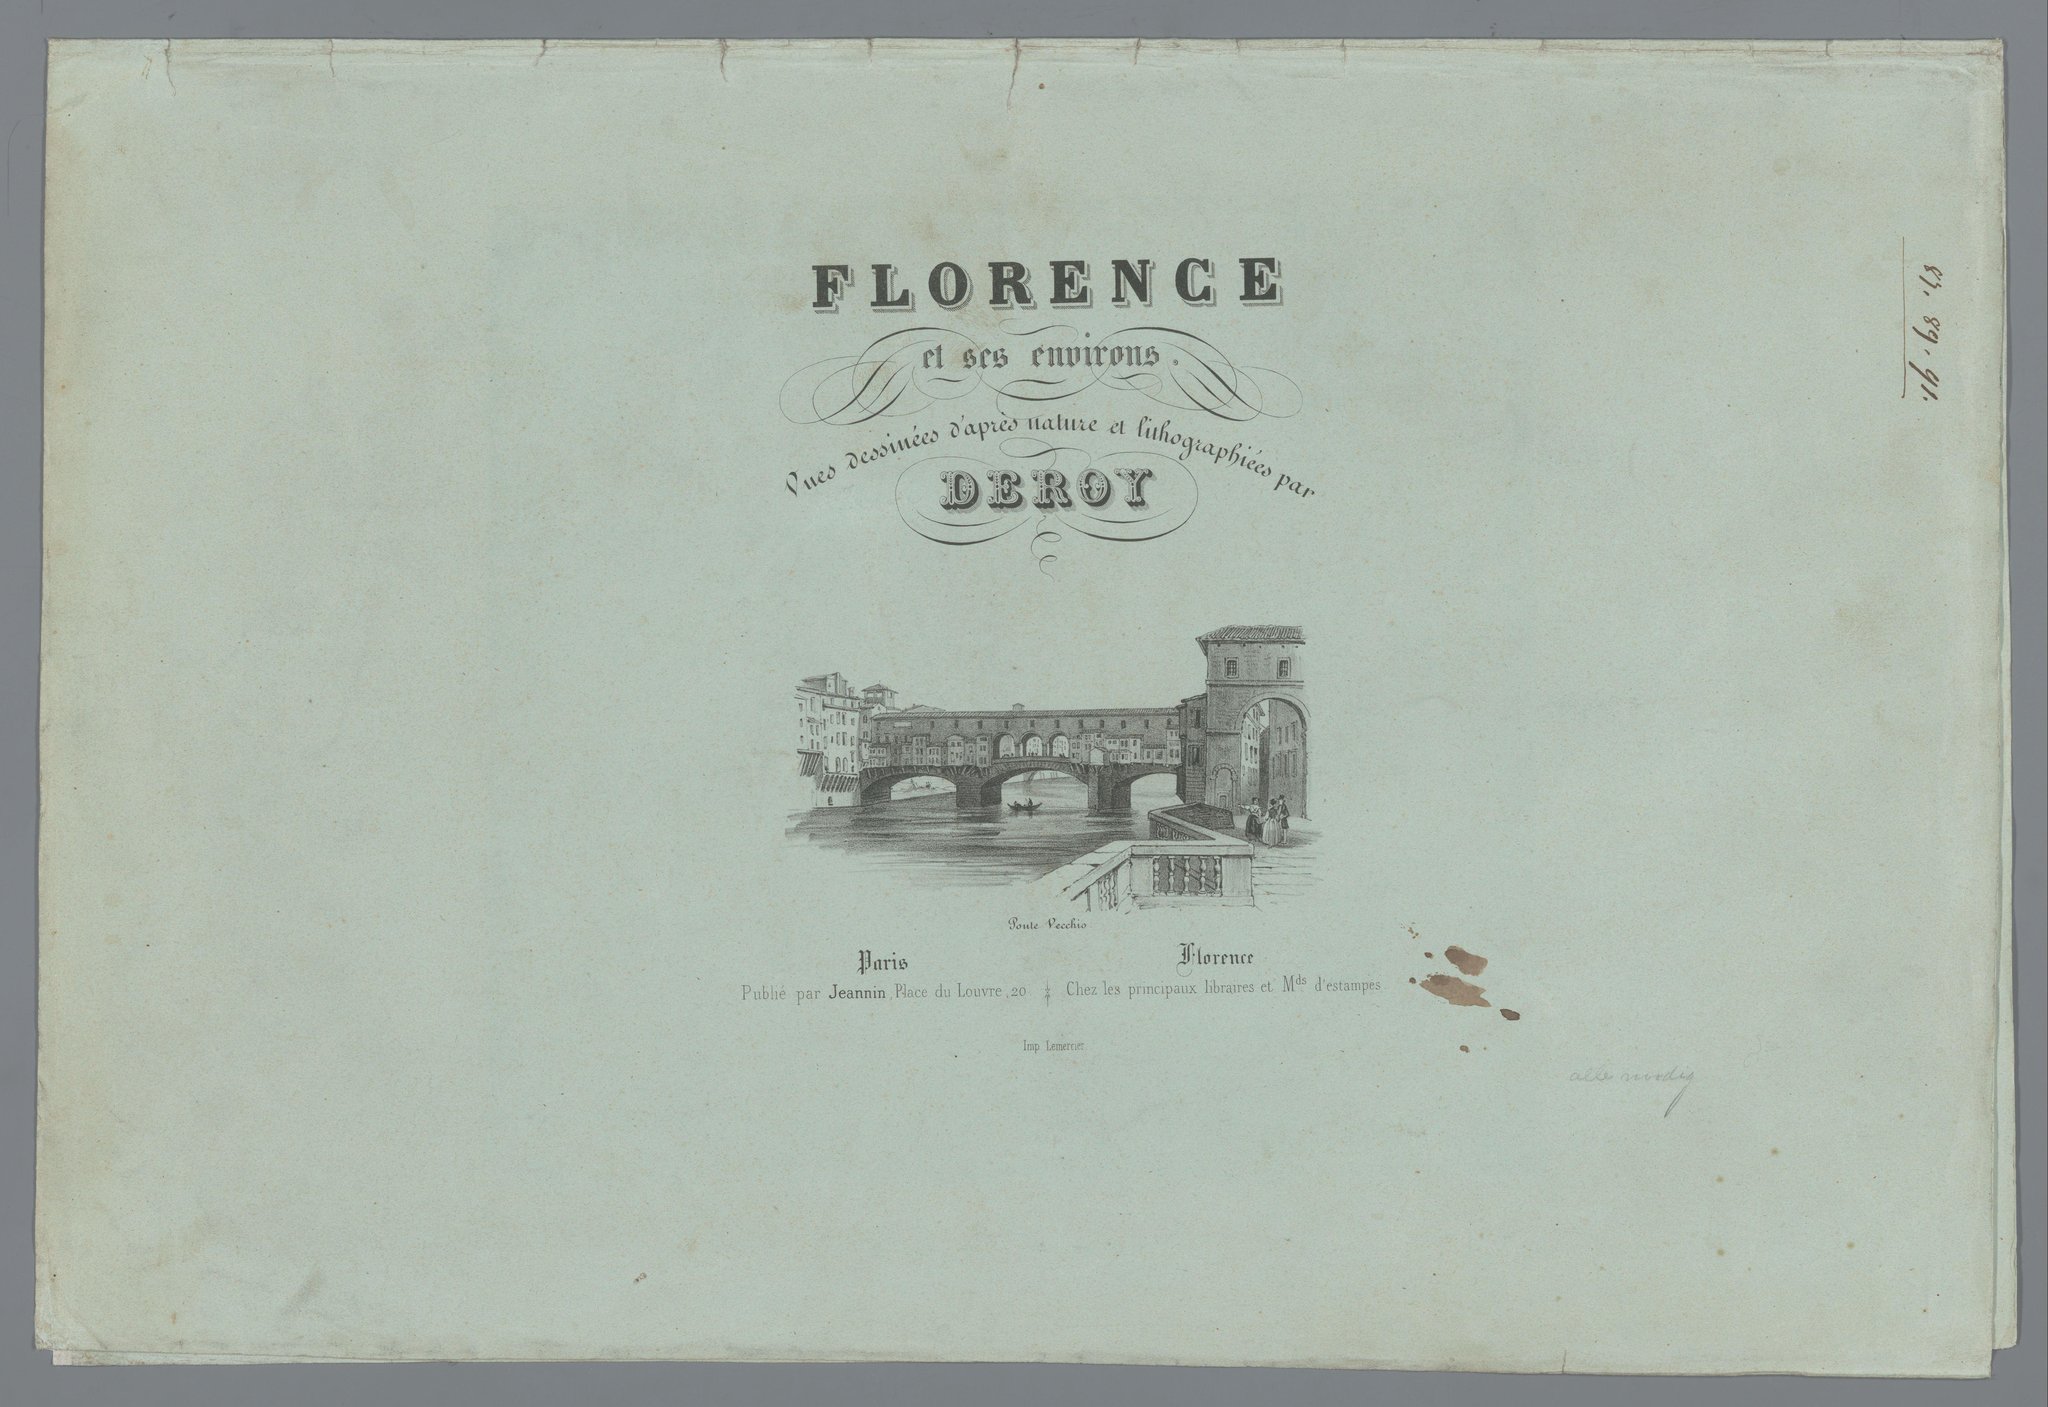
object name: wrapper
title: Omslag voor: Gezichten in Florence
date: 1843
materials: paper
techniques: lithograph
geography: paris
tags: bridge in city across river, canal, etc. (+ city(-scape) with figures, staffage)